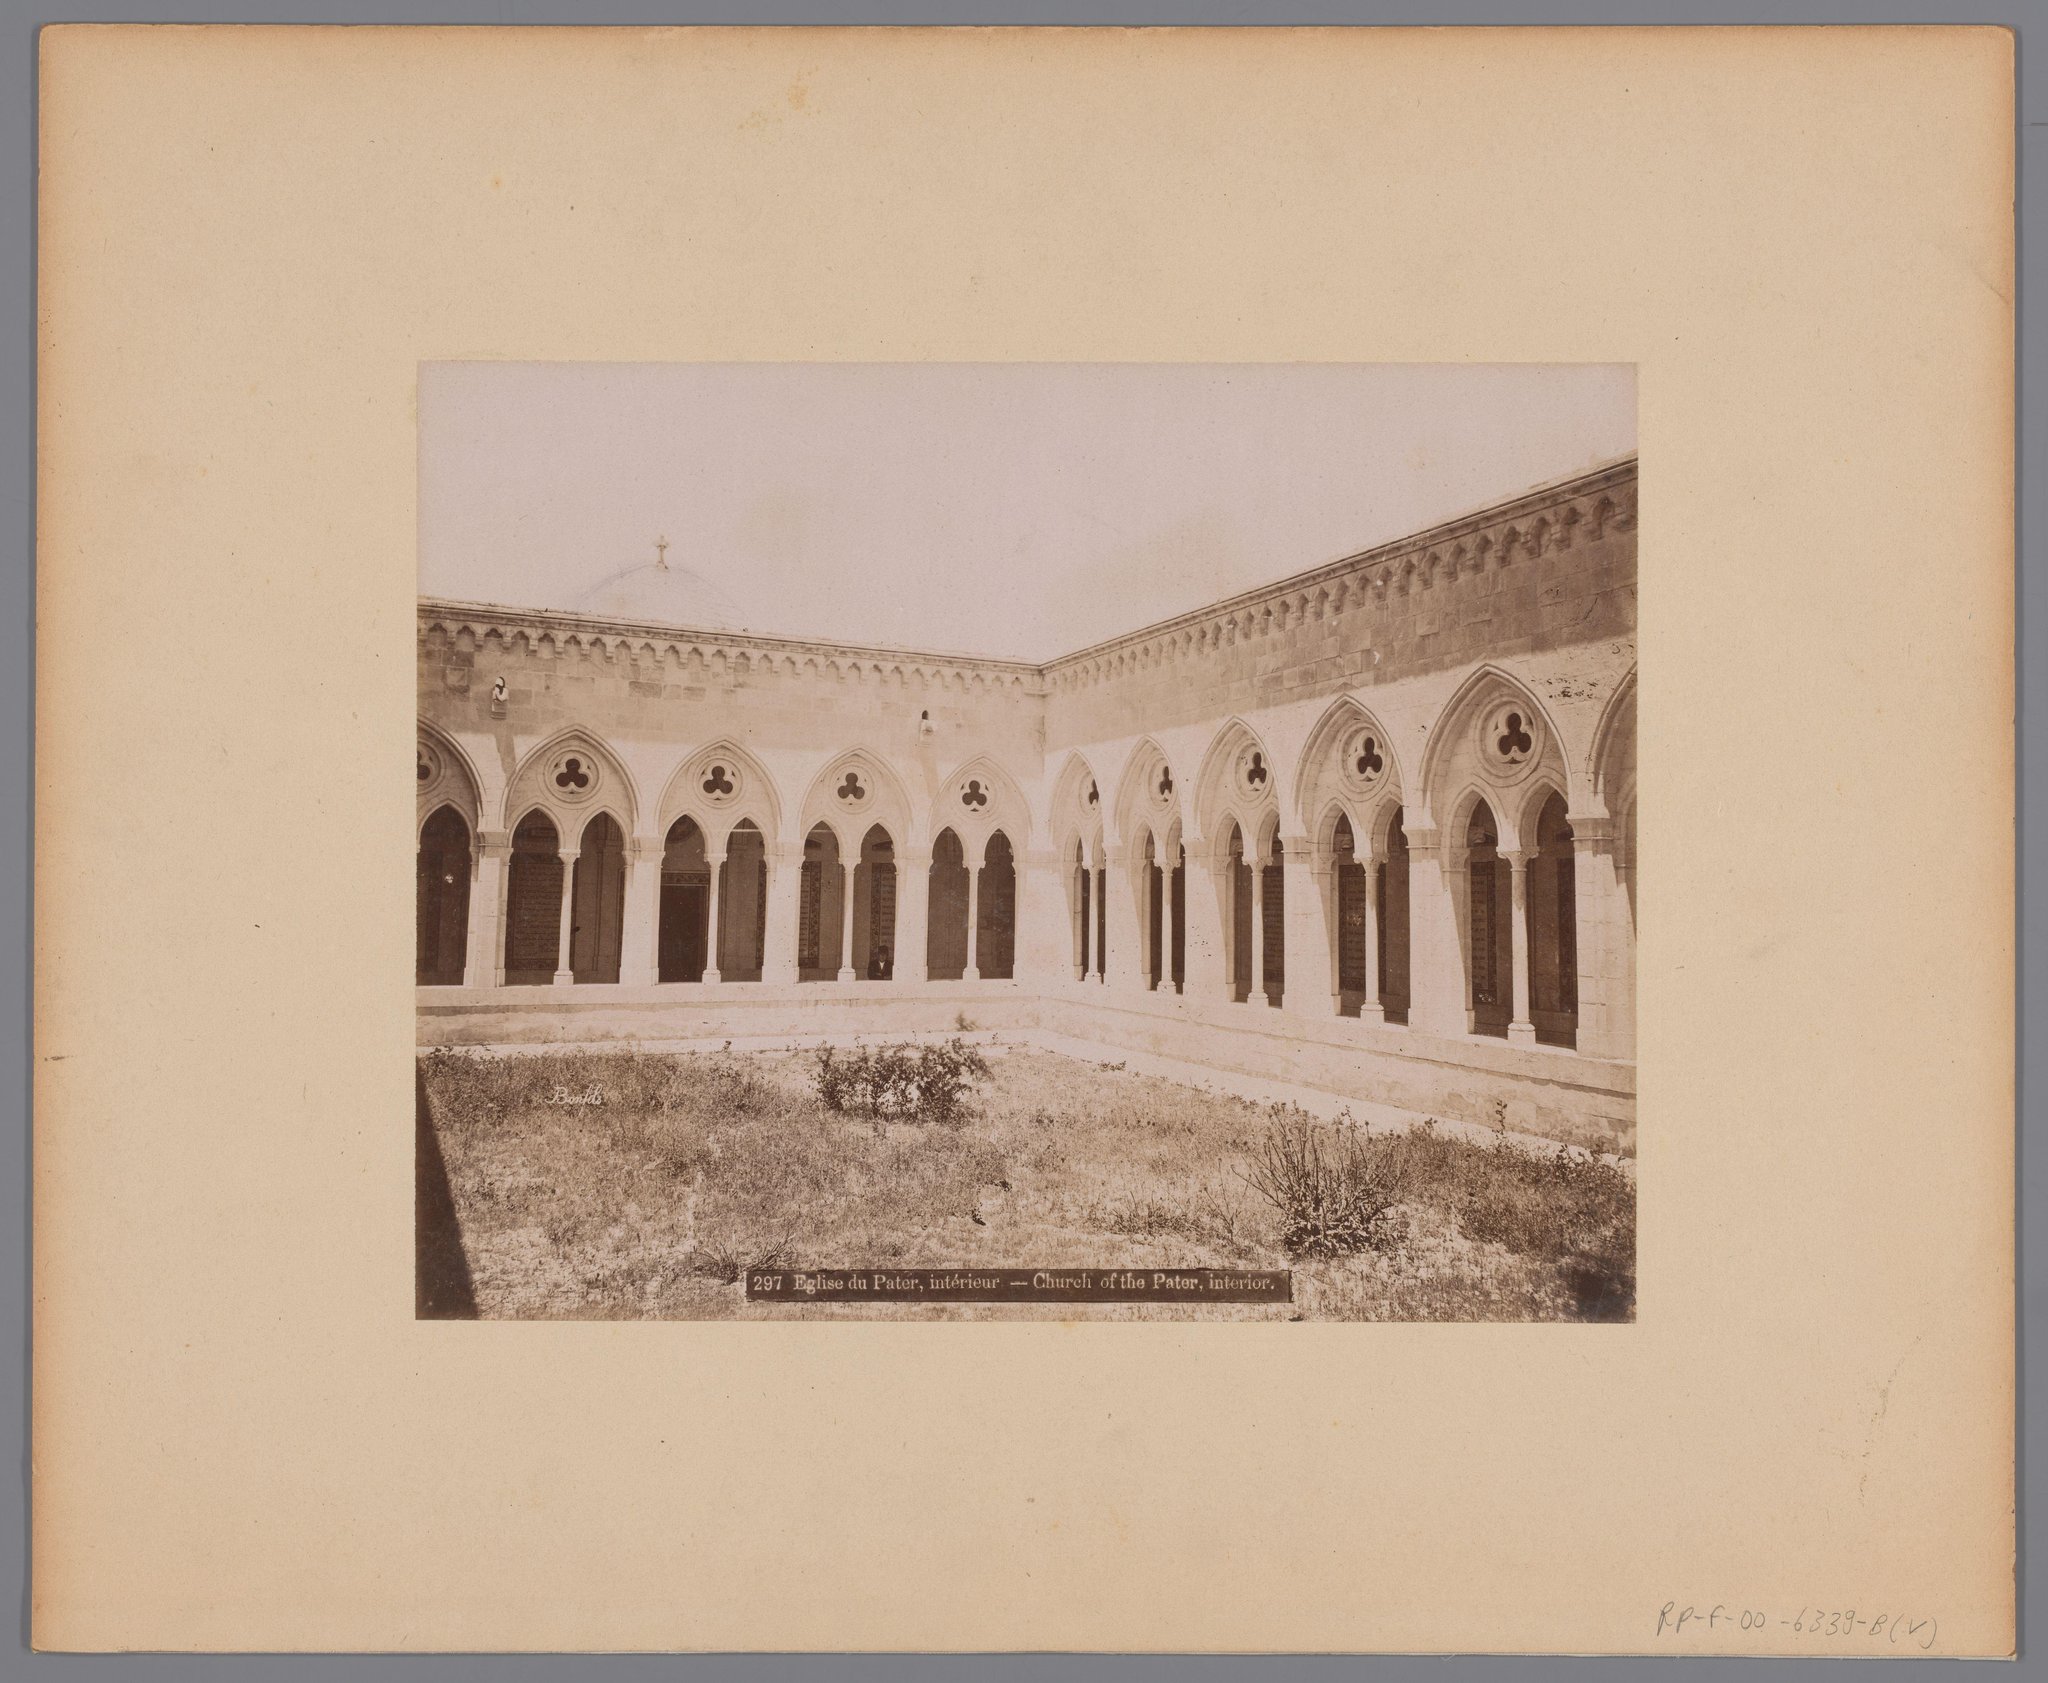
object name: photograph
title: "Eglise du Pater, intéieur - Chruch of the Pater, Interior", Olijfberg bij Jeruzalem, Palestina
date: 1880-1890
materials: cardboard, paper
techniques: albumen print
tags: olijfberg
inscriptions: inscription: ‘297. Eglise du Pater, intérieur - Chruch of the Pater, interior.’, signature: ‘Bonfils’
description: Aanzicht op de omgang van de Pater Noster-kerk, Olijfberg bij Jeruzalem, Palestina.